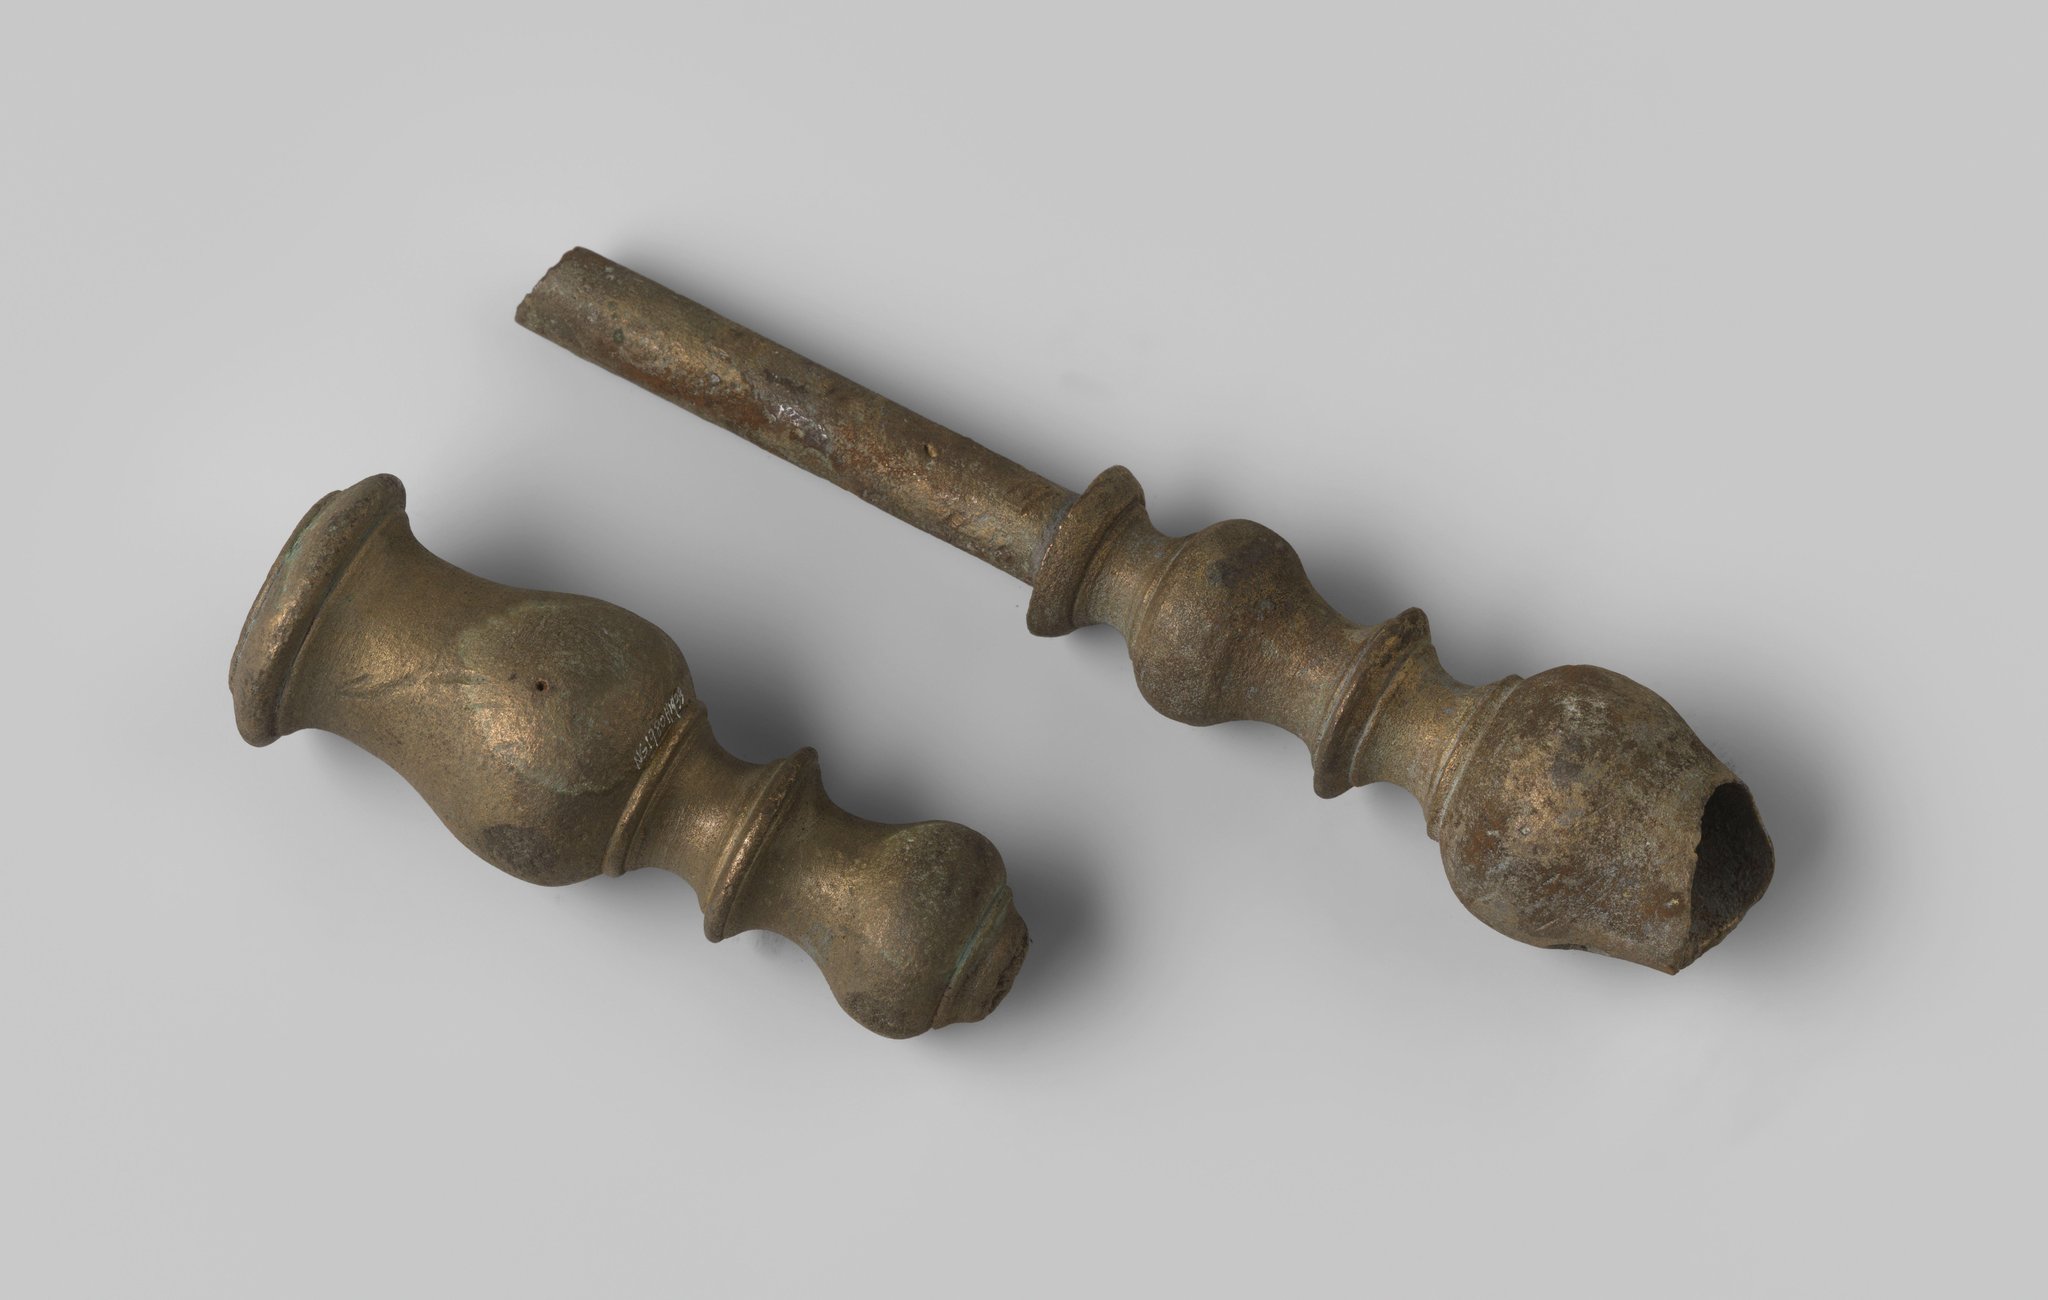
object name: candlestick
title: Fragment steel van een of twee kandelaars uit het wrak van de Oost-Indiëvaarder Hollandia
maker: Anonymous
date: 1700-1743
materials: copper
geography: netherlands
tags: verenigde oostindische compagnie, hollandia (schip), annet